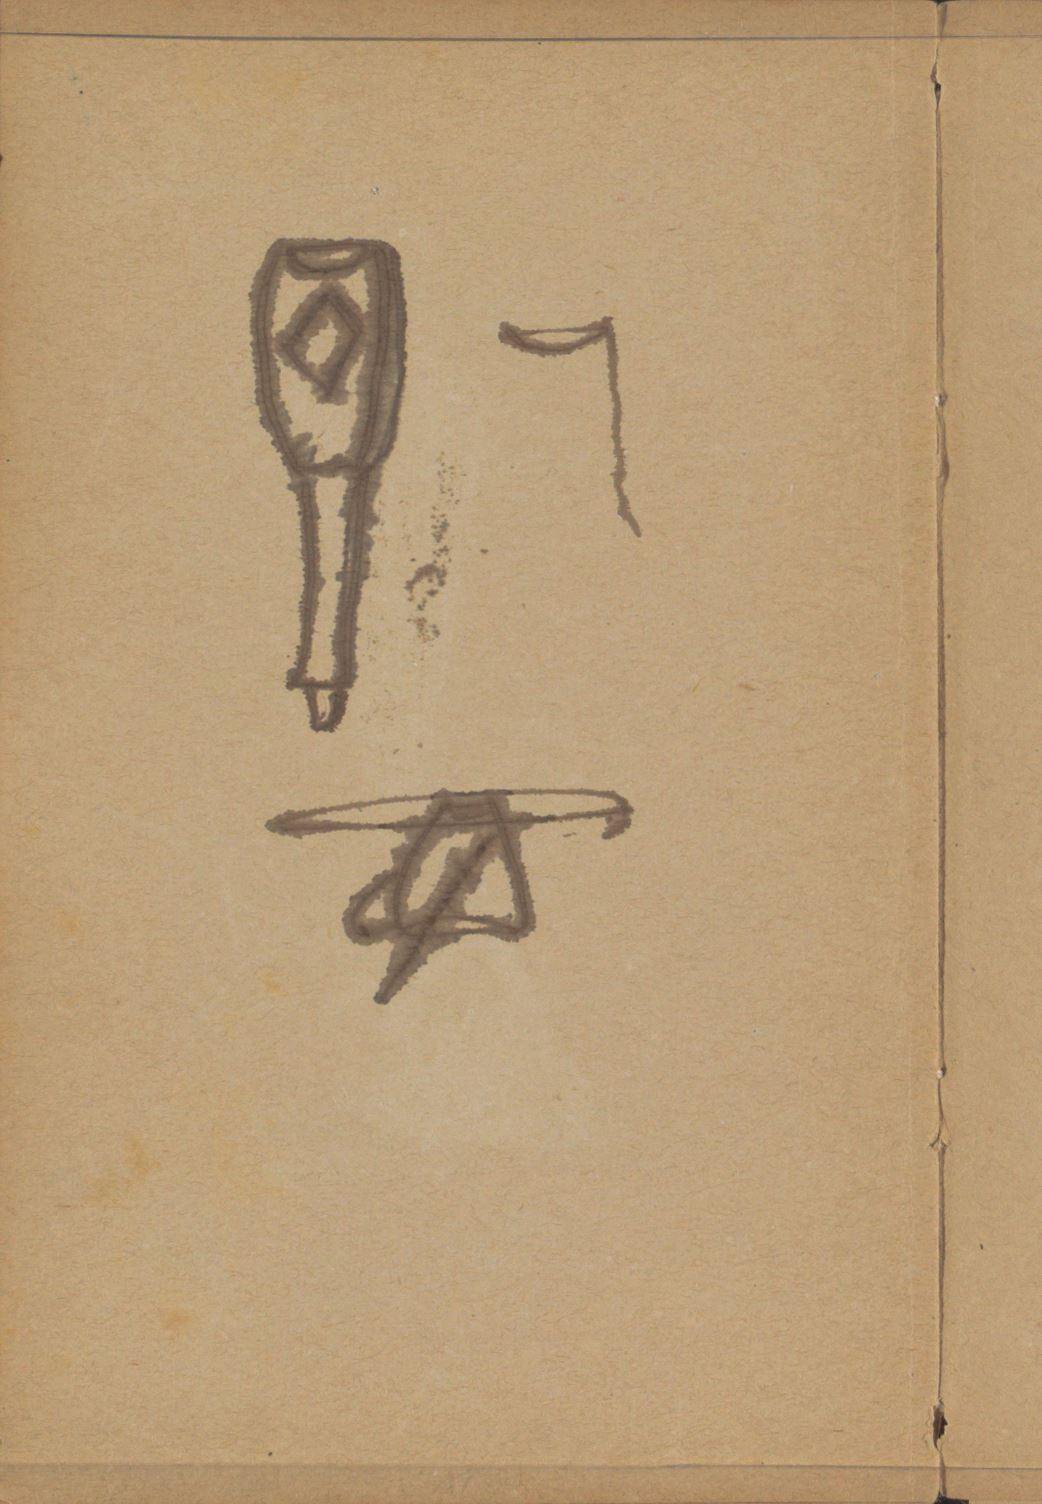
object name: sketchbook leaf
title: Studies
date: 1887-1891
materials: ink, paper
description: Pagina 15 uit een schetsboek met 83 bladen.